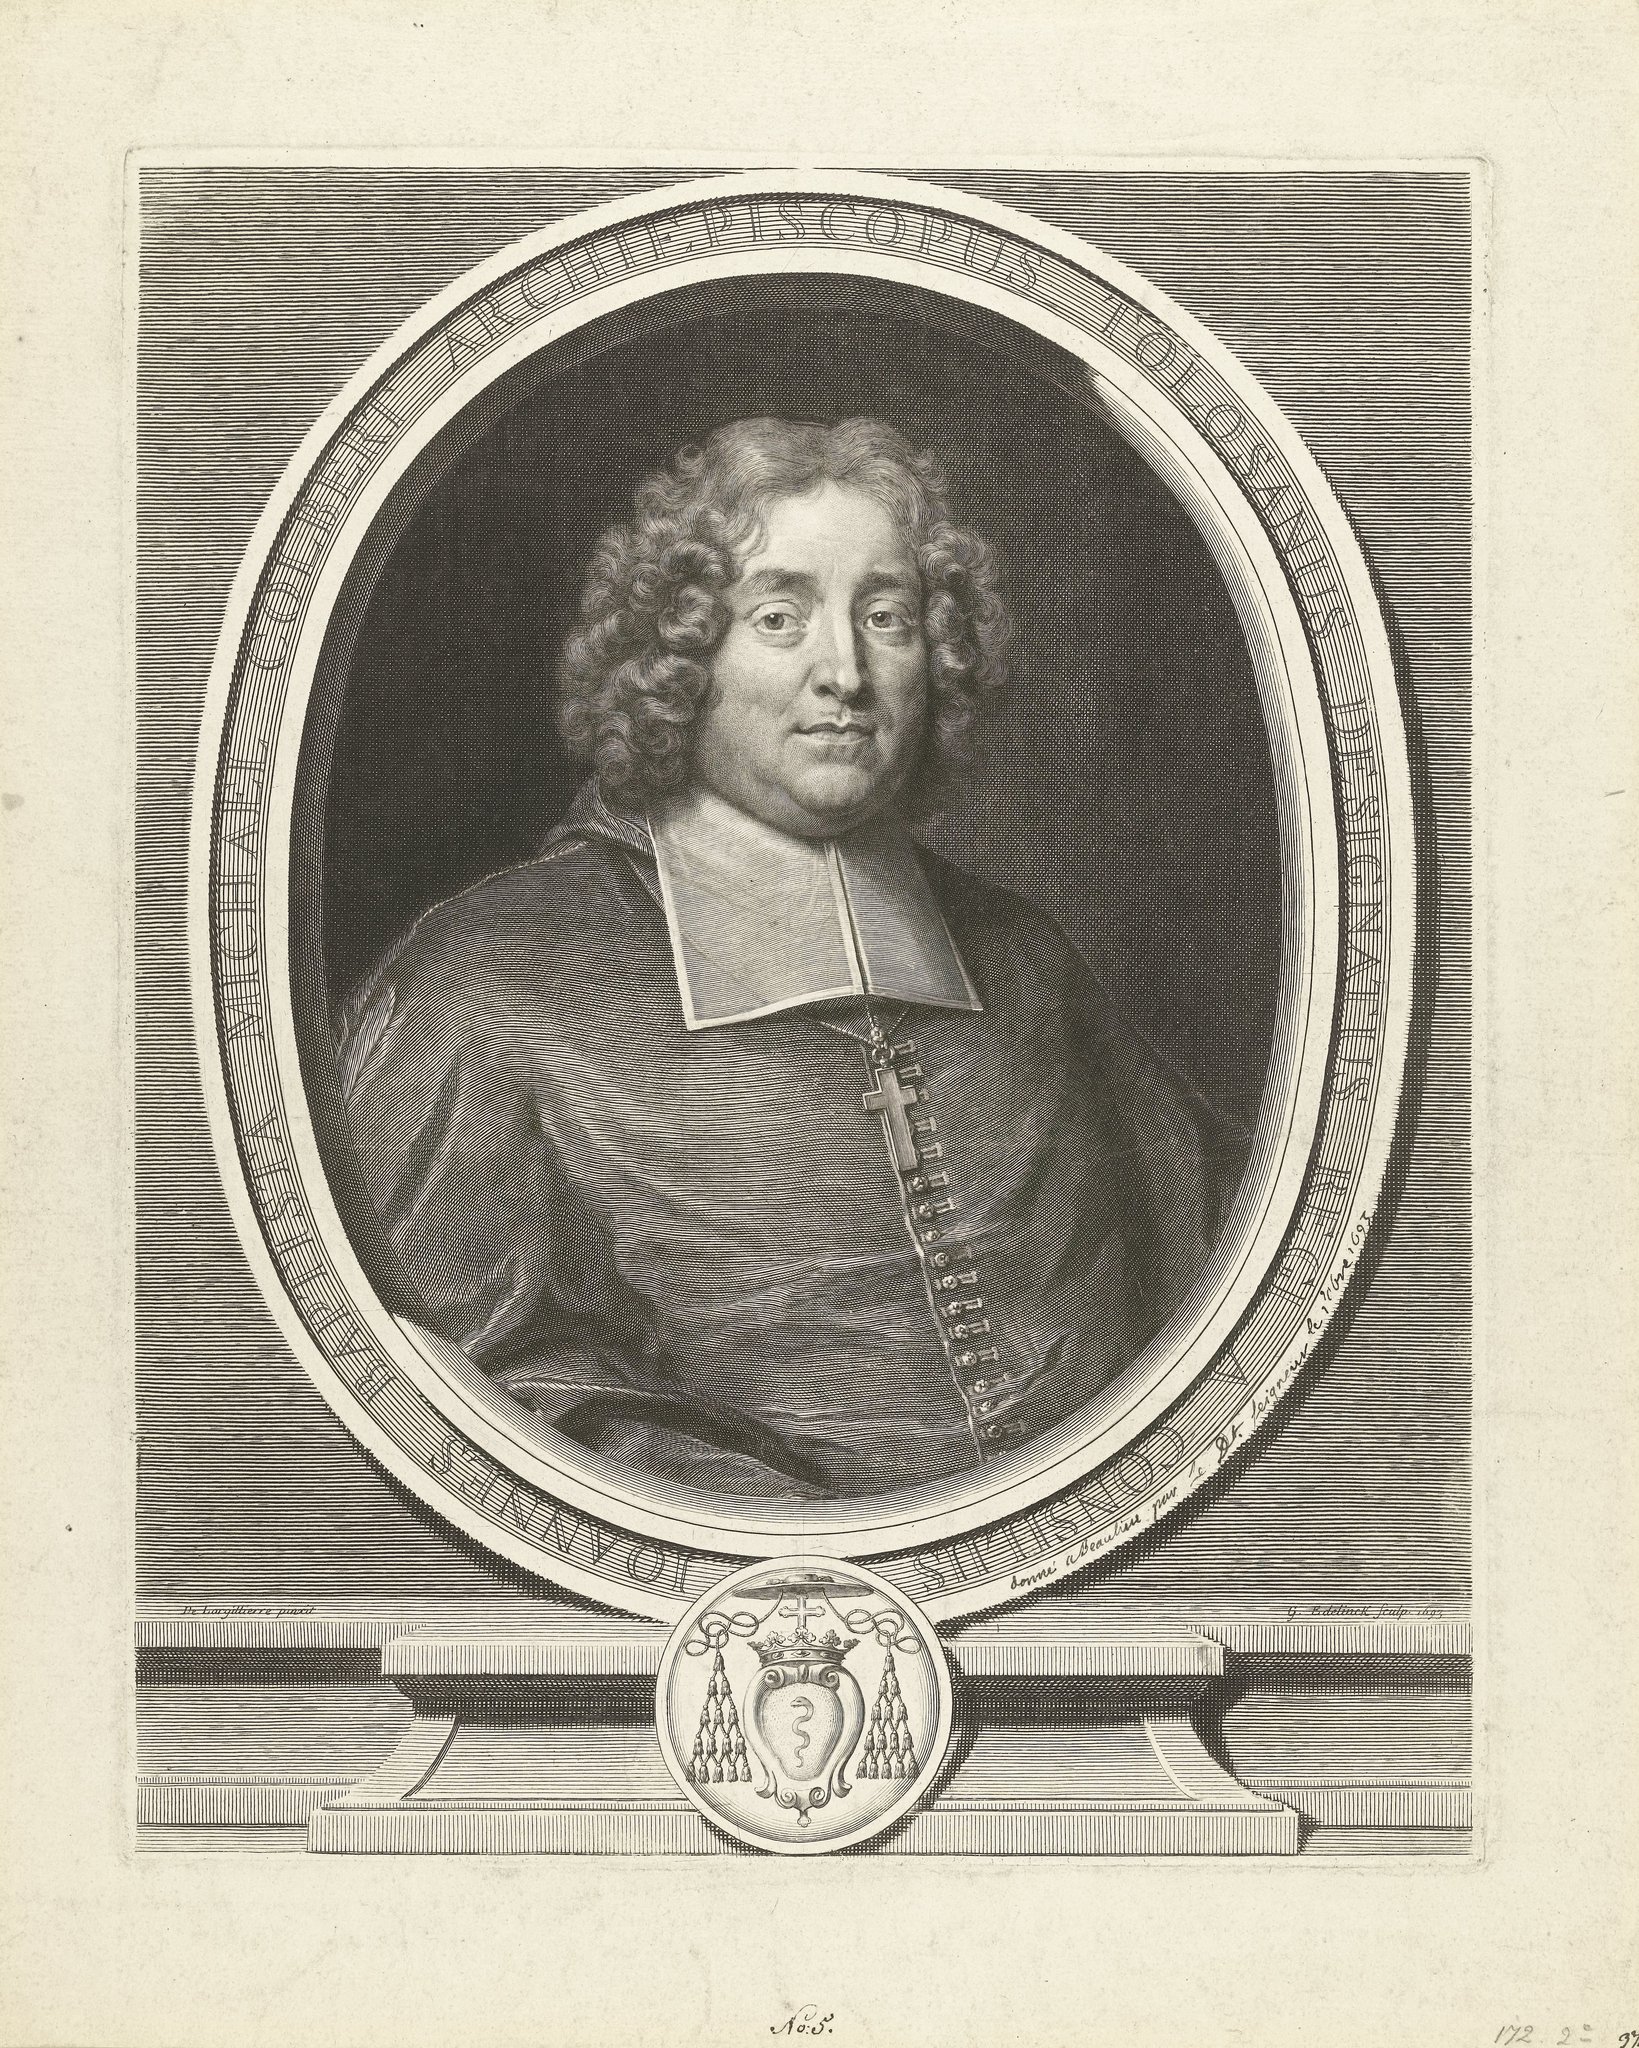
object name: print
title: Ioannes Baptista Michael Colbert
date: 1693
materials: paper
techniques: engraving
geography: france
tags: paris, france, jean-baptiste michel colbert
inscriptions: collector's mark: Lugt 2228, inscription: ‘donné a Beaulieu par le ...seigneur le 1 'obre 1693’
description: Portret van Jean-Baptiste Michel Colbert (1640-1710), aartsbisschop van Toulouse, afgebeeld in ovale omlijsting met wapen.